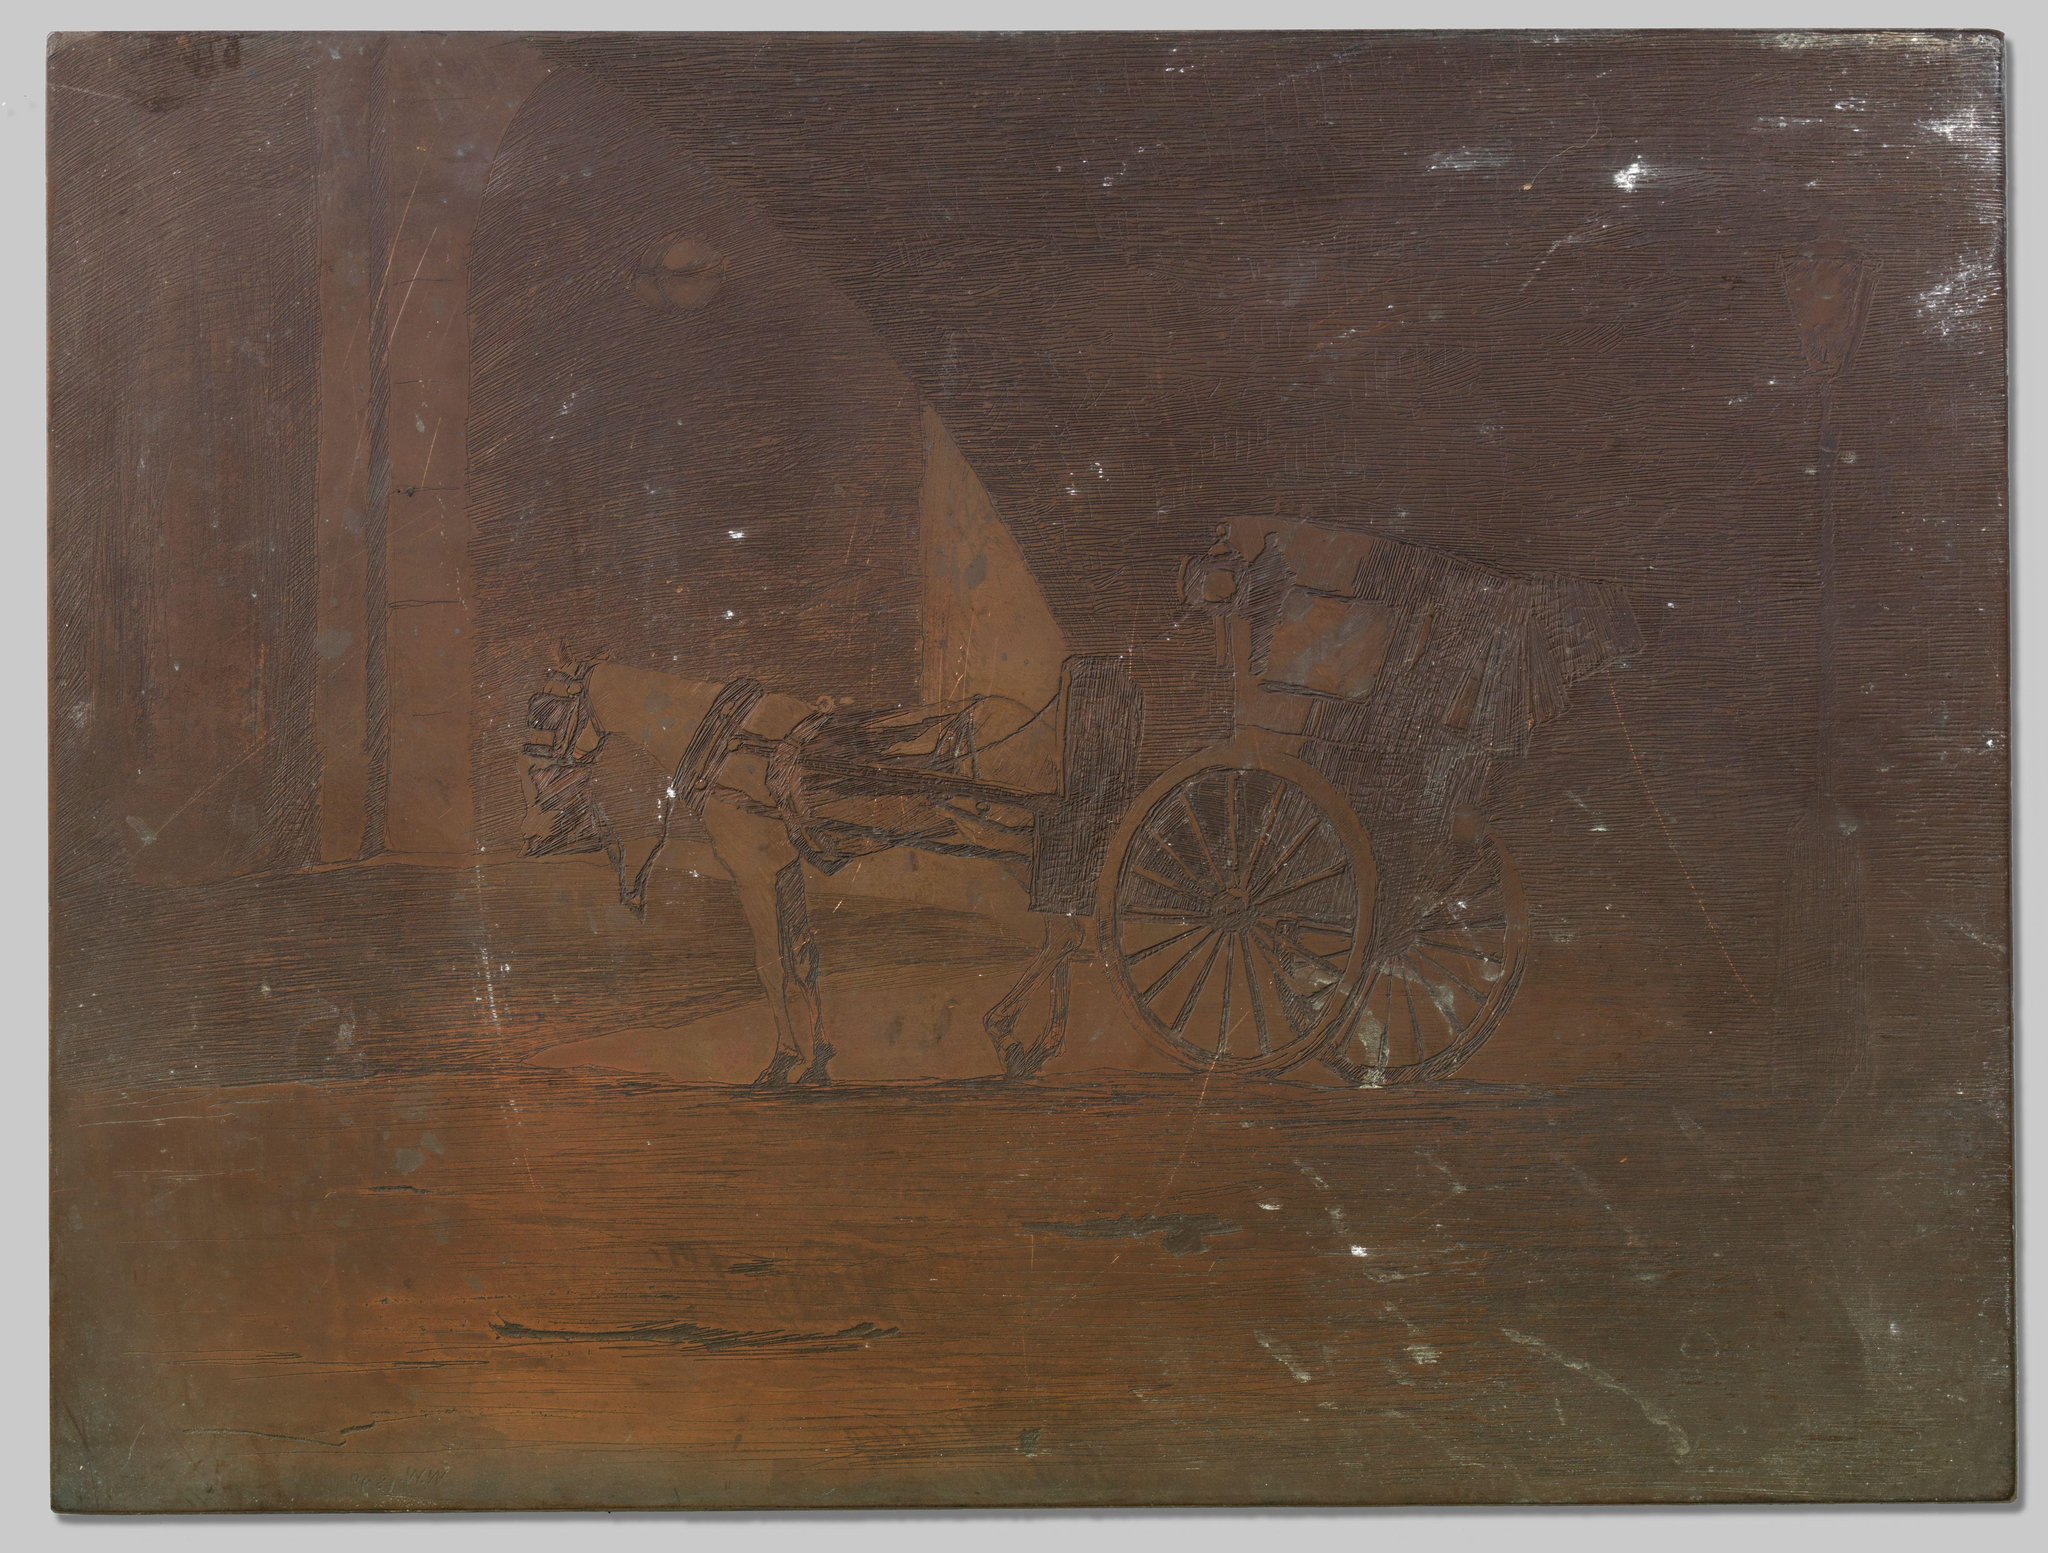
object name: copper plate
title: Rijtuig onder Waterloo Bridge, Londen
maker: willem witsen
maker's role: draughtsman, painter, print maker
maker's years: 1860-1923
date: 1890-1906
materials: copper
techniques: etching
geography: london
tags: waterloo bridge